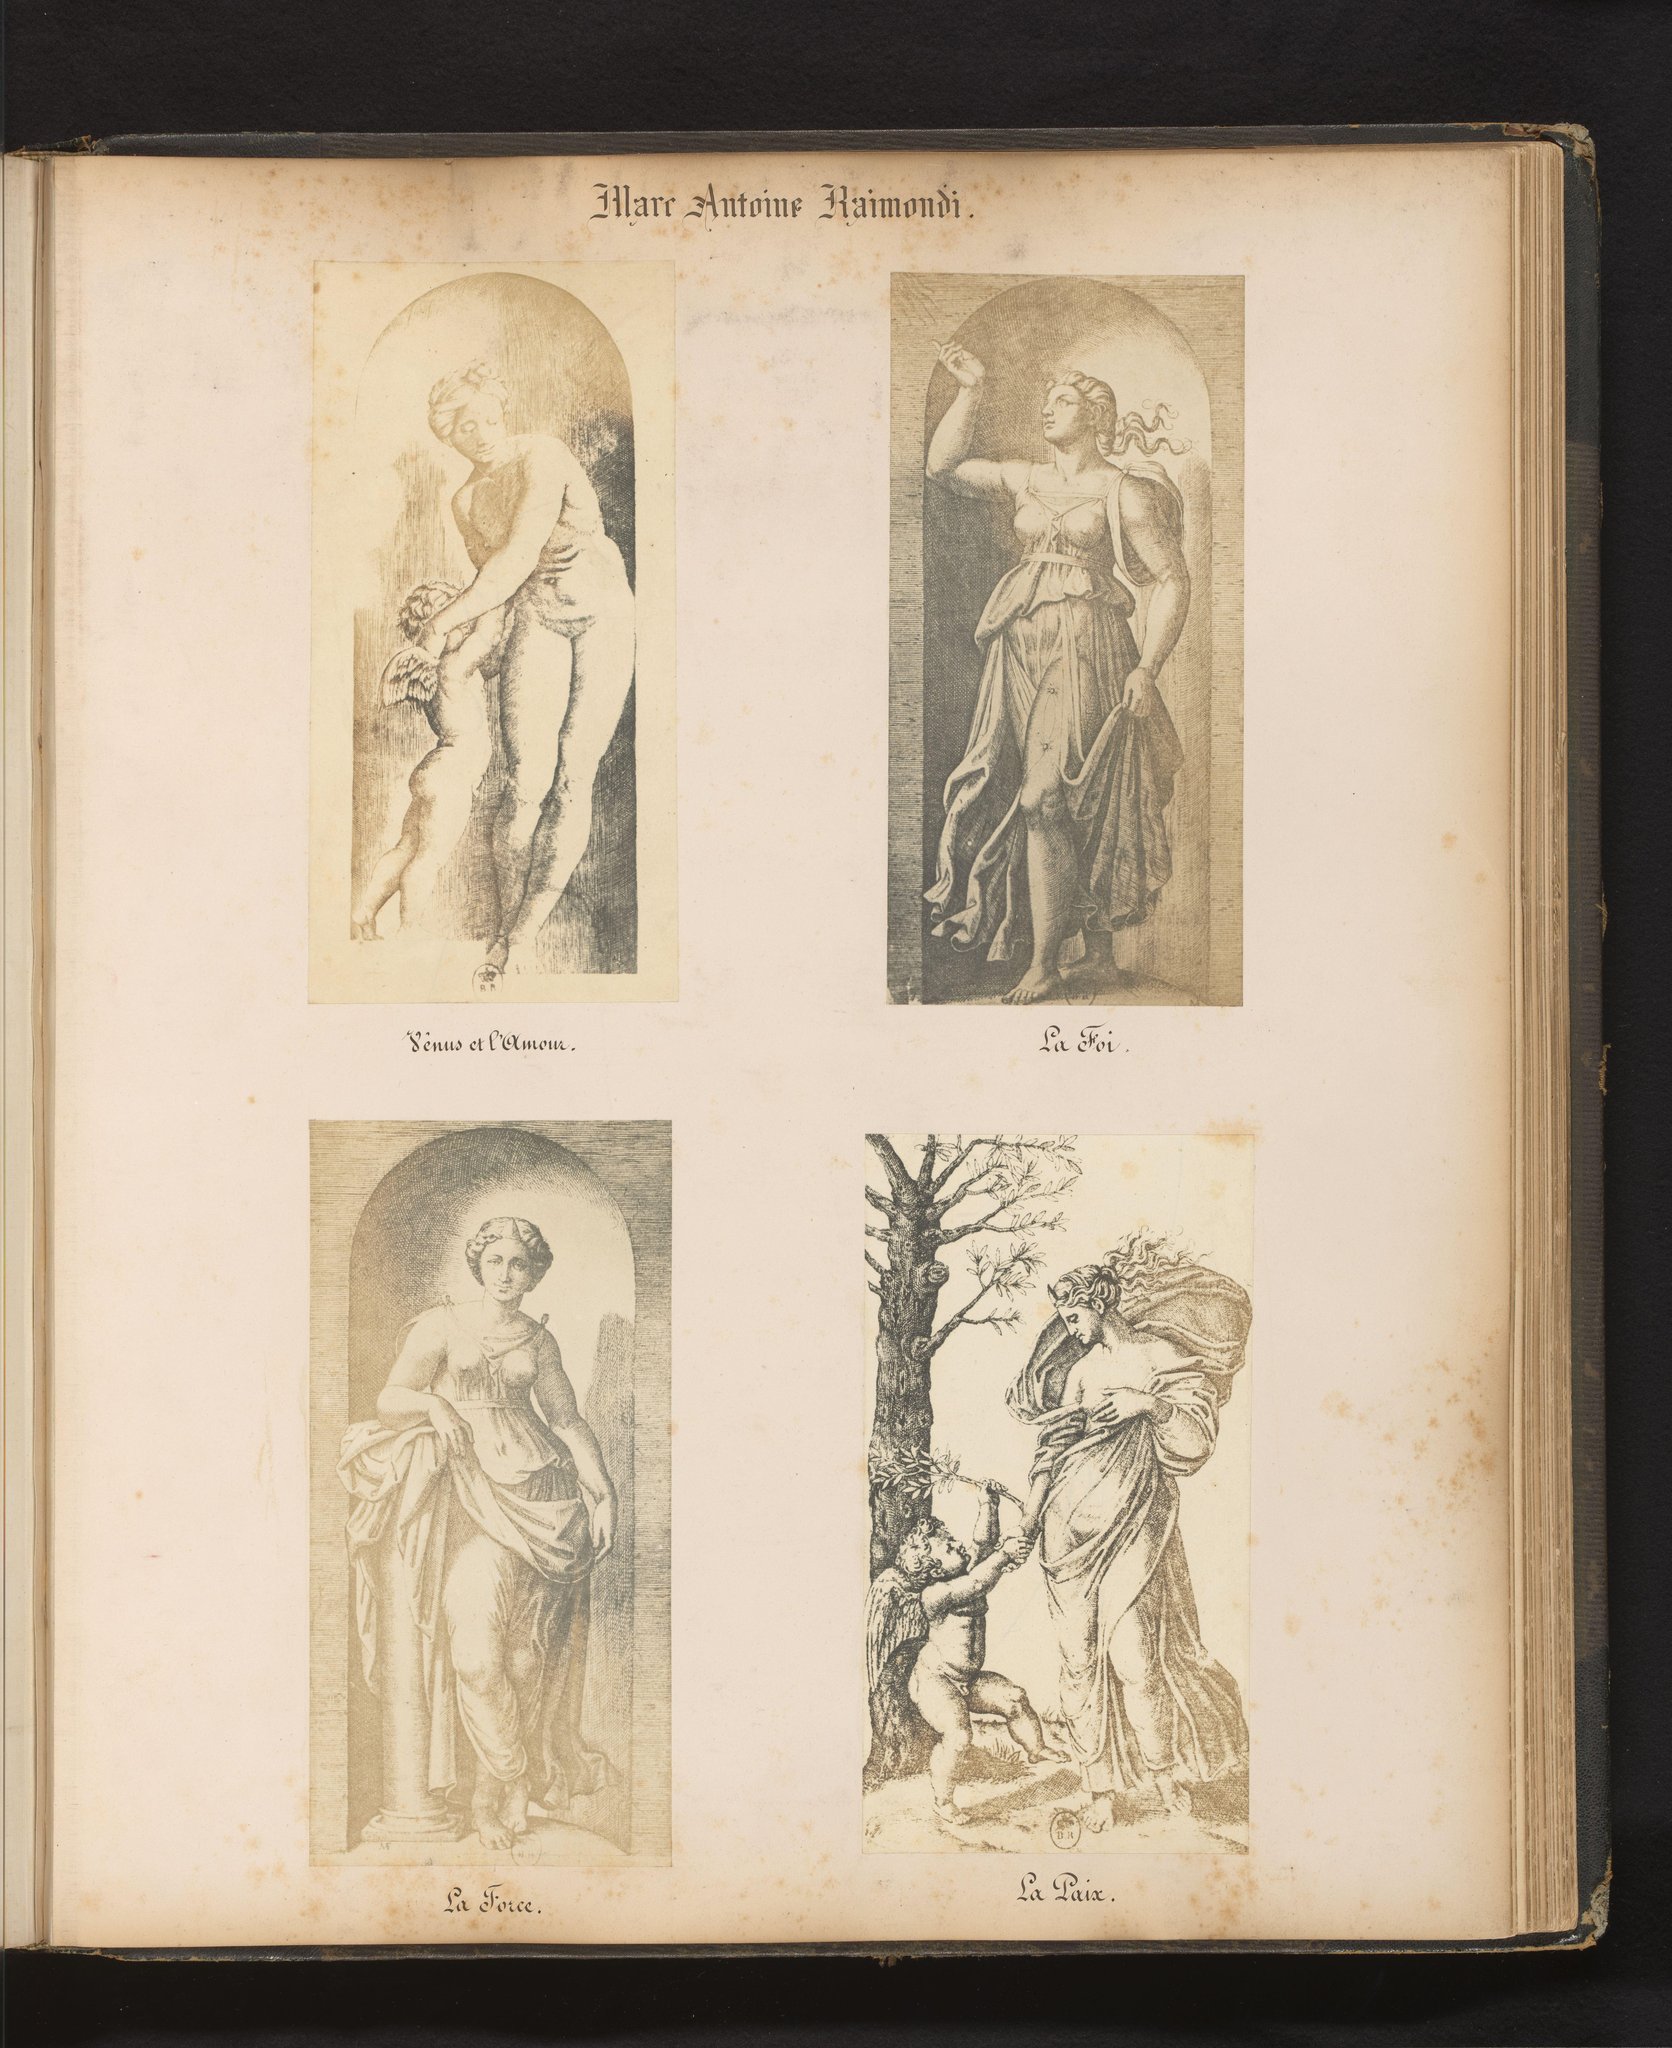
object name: photograph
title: Fotoreproductie van een gravure van Vrede door Marcantonio Raimondi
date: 1848-1853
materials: photographic support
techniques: salted paper print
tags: symbols, allegories of peace, 'pax'; 'pace' (ripa)